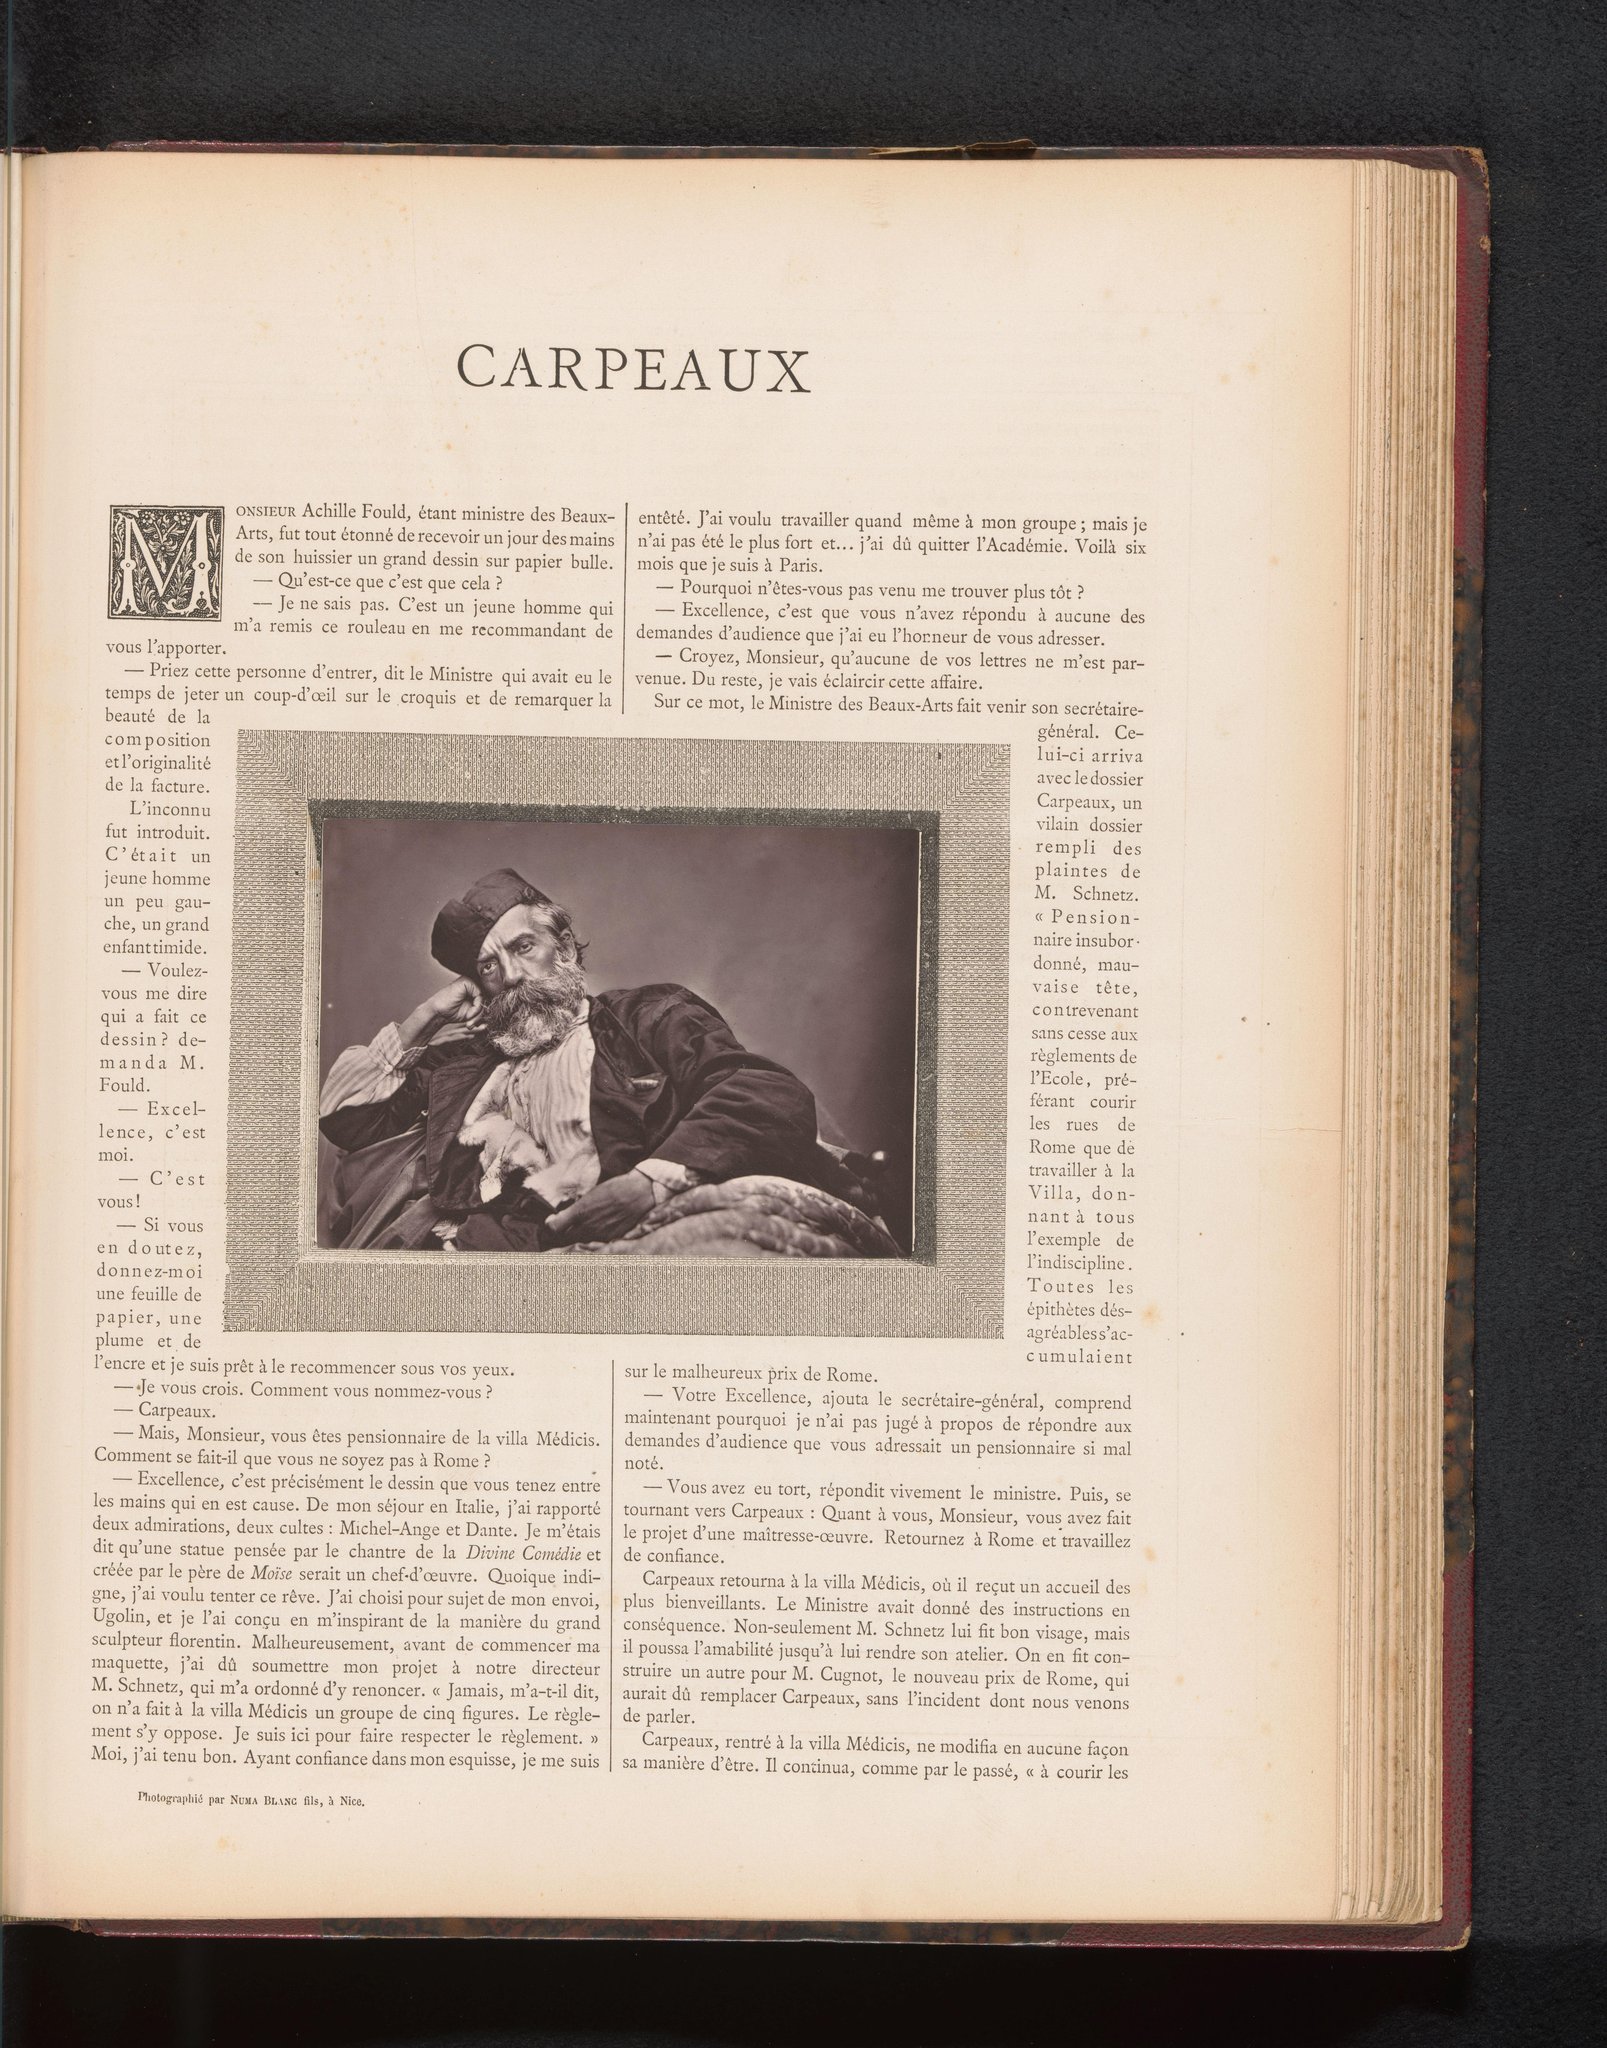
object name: page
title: Portret van Jean-Baptiste Carpeaux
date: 1871-1876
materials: paper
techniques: woodburytype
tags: print maker, draughtsman, sculptor, jean baptiste carpeaux, adult man, historical persons